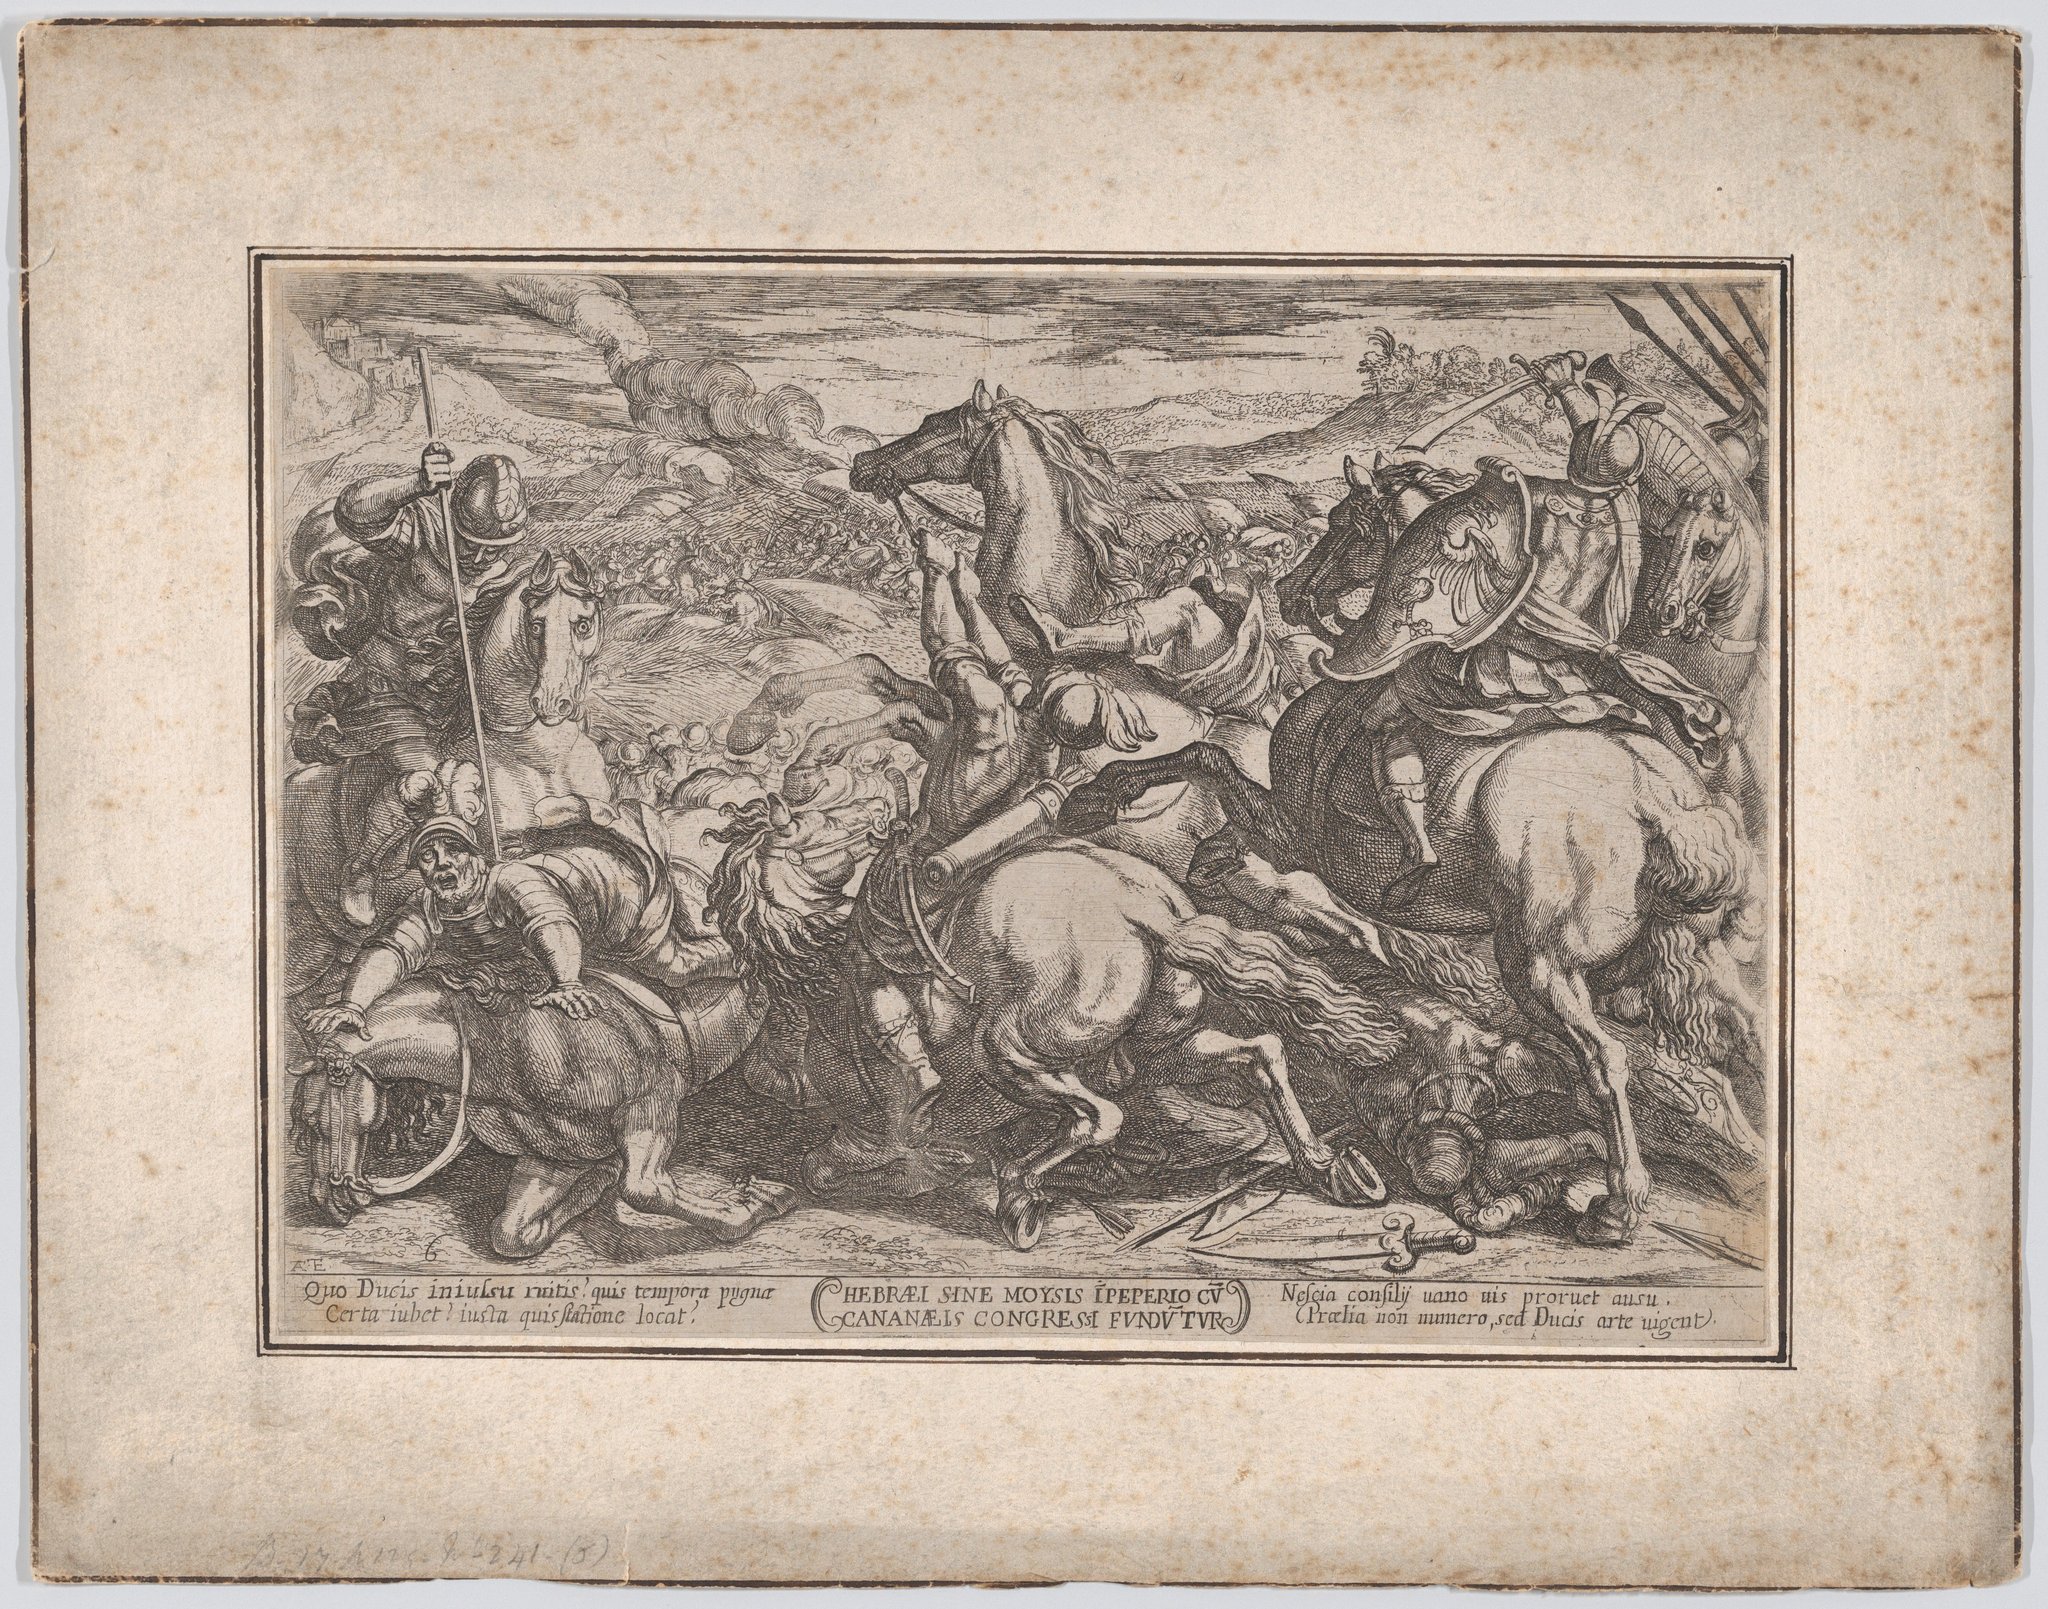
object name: print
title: Plate 6: The Israelites Defeated by the Canaanites for Having Disobeyed Moses, from 'The Battles of the Old Testament'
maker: antonio tempesta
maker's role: artist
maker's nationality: italian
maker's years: 1555-1630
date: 1590-1610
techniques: etching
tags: battles,soldiers,weapons,horses